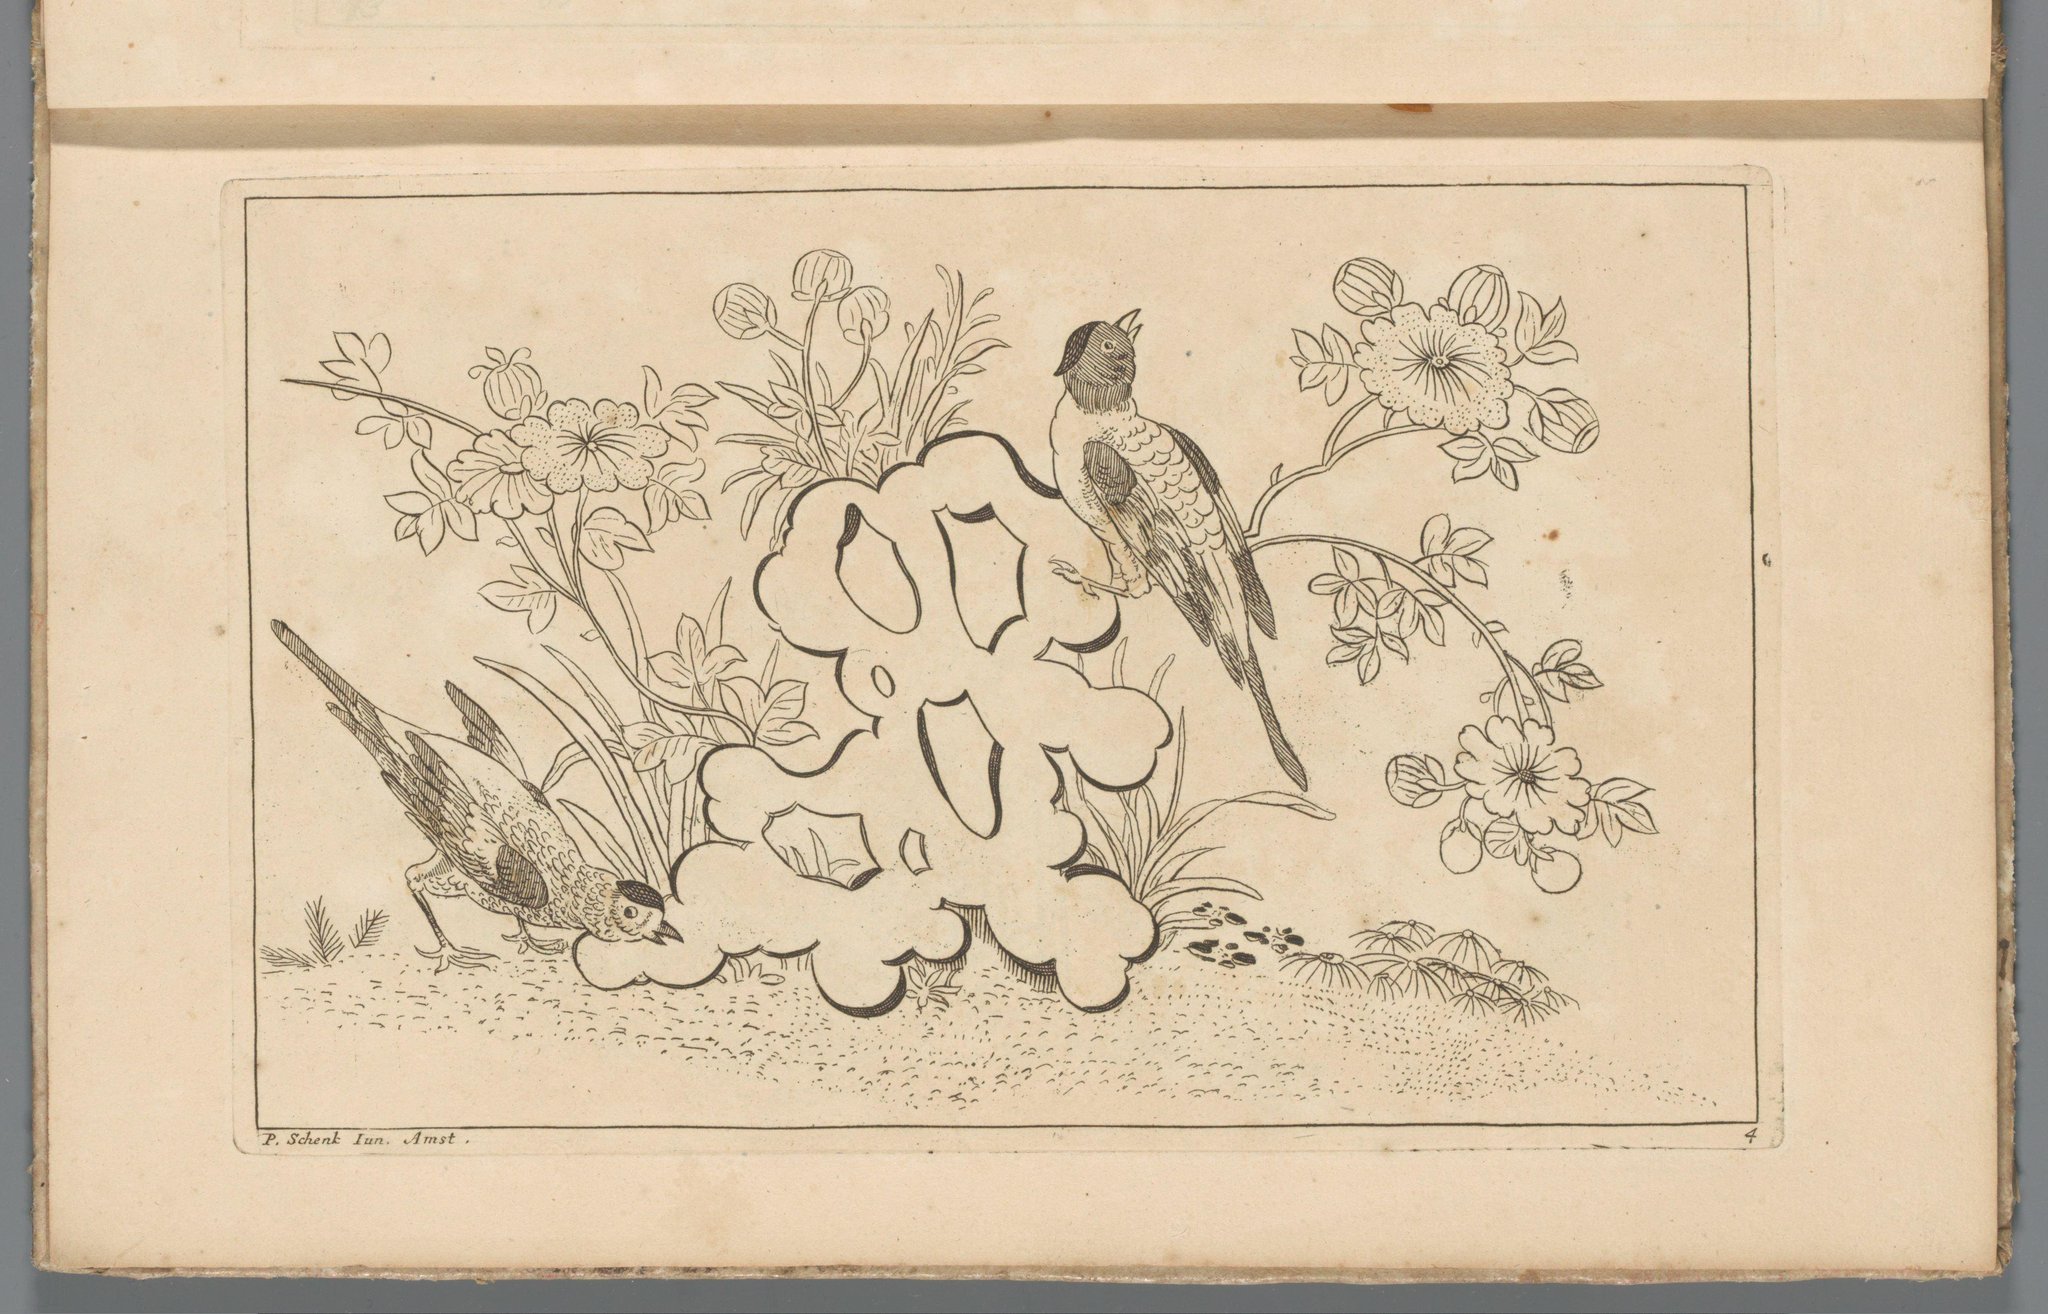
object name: album leaf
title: Chinese bloemen en vogels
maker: pieter schenk (ii)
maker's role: draughtsman, print maker, publisher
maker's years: 1693-1775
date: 1727-1775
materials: paper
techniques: etching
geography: amsterdam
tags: flowers, chinese, birds, trees (+ flowers, blossom, blossoming)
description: Gestileerde rots of boomstronk met twee vogels. Daarachter een bloeiende struik. Prent maakt deel uit van een album.